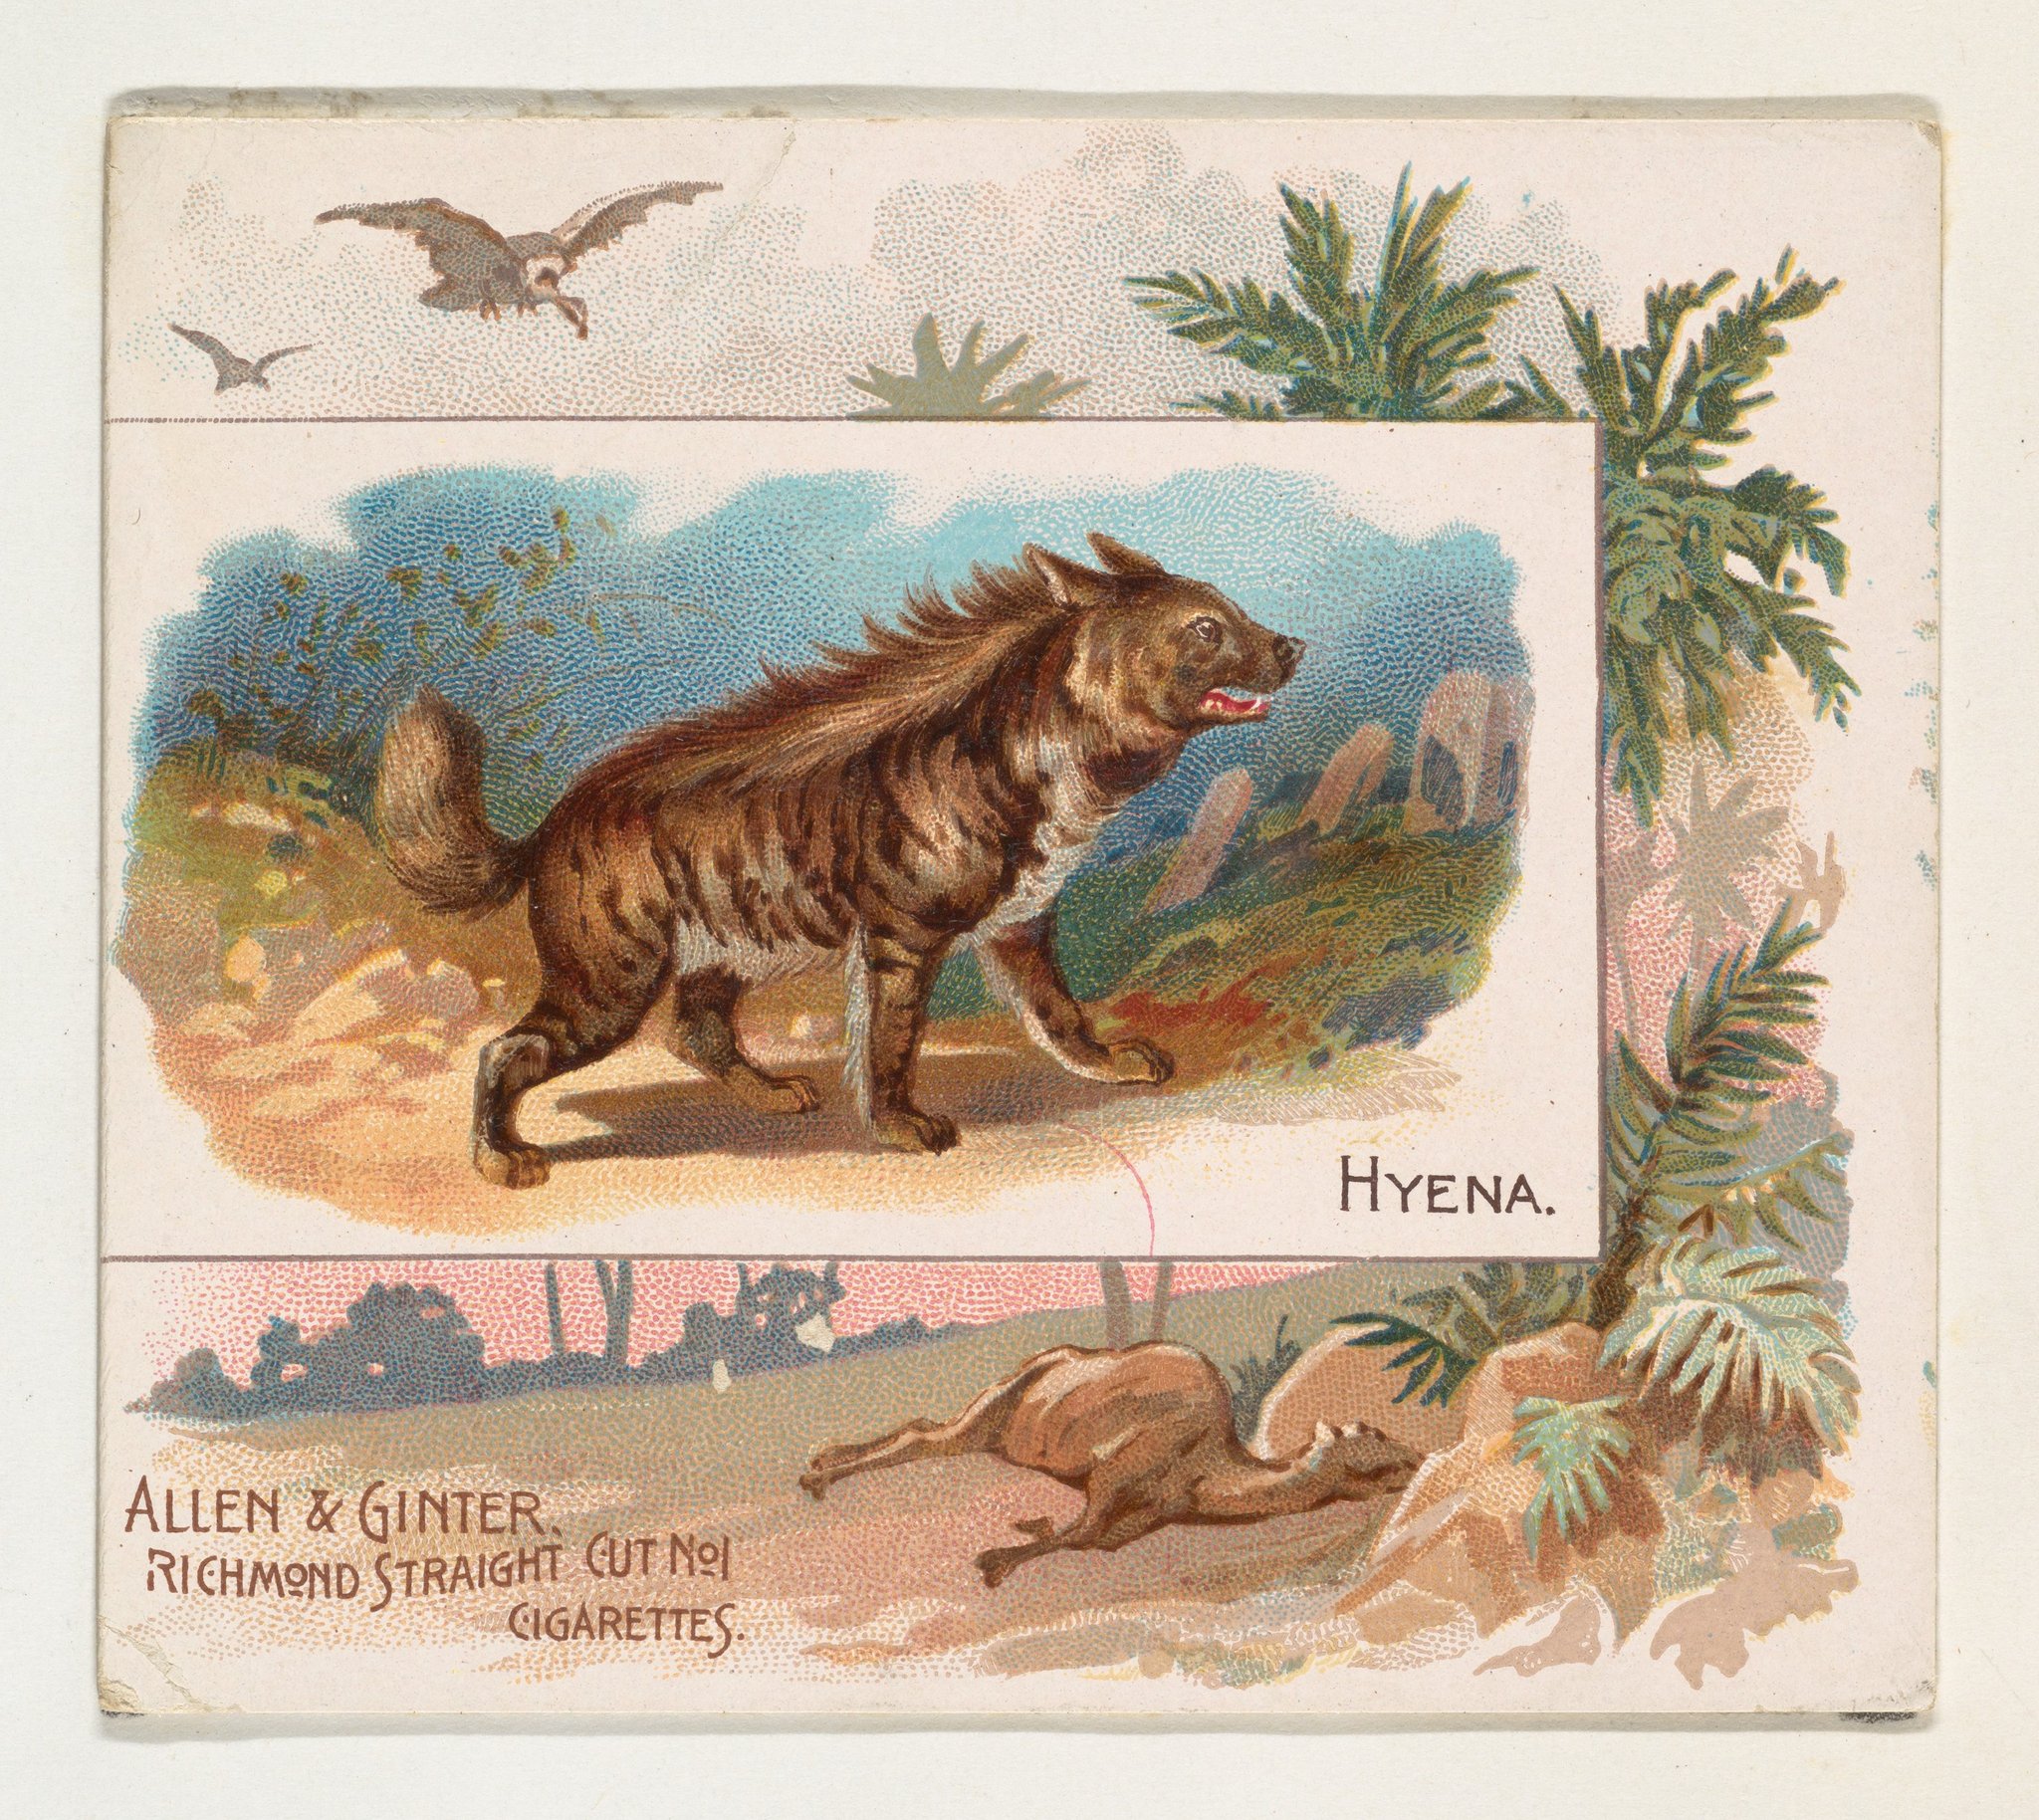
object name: print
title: Hyena, from Quadrupeds series (N41) for Allen & Ginter Cigarettes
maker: allen & ginter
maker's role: publisher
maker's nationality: american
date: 1890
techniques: color lithograph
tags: animals